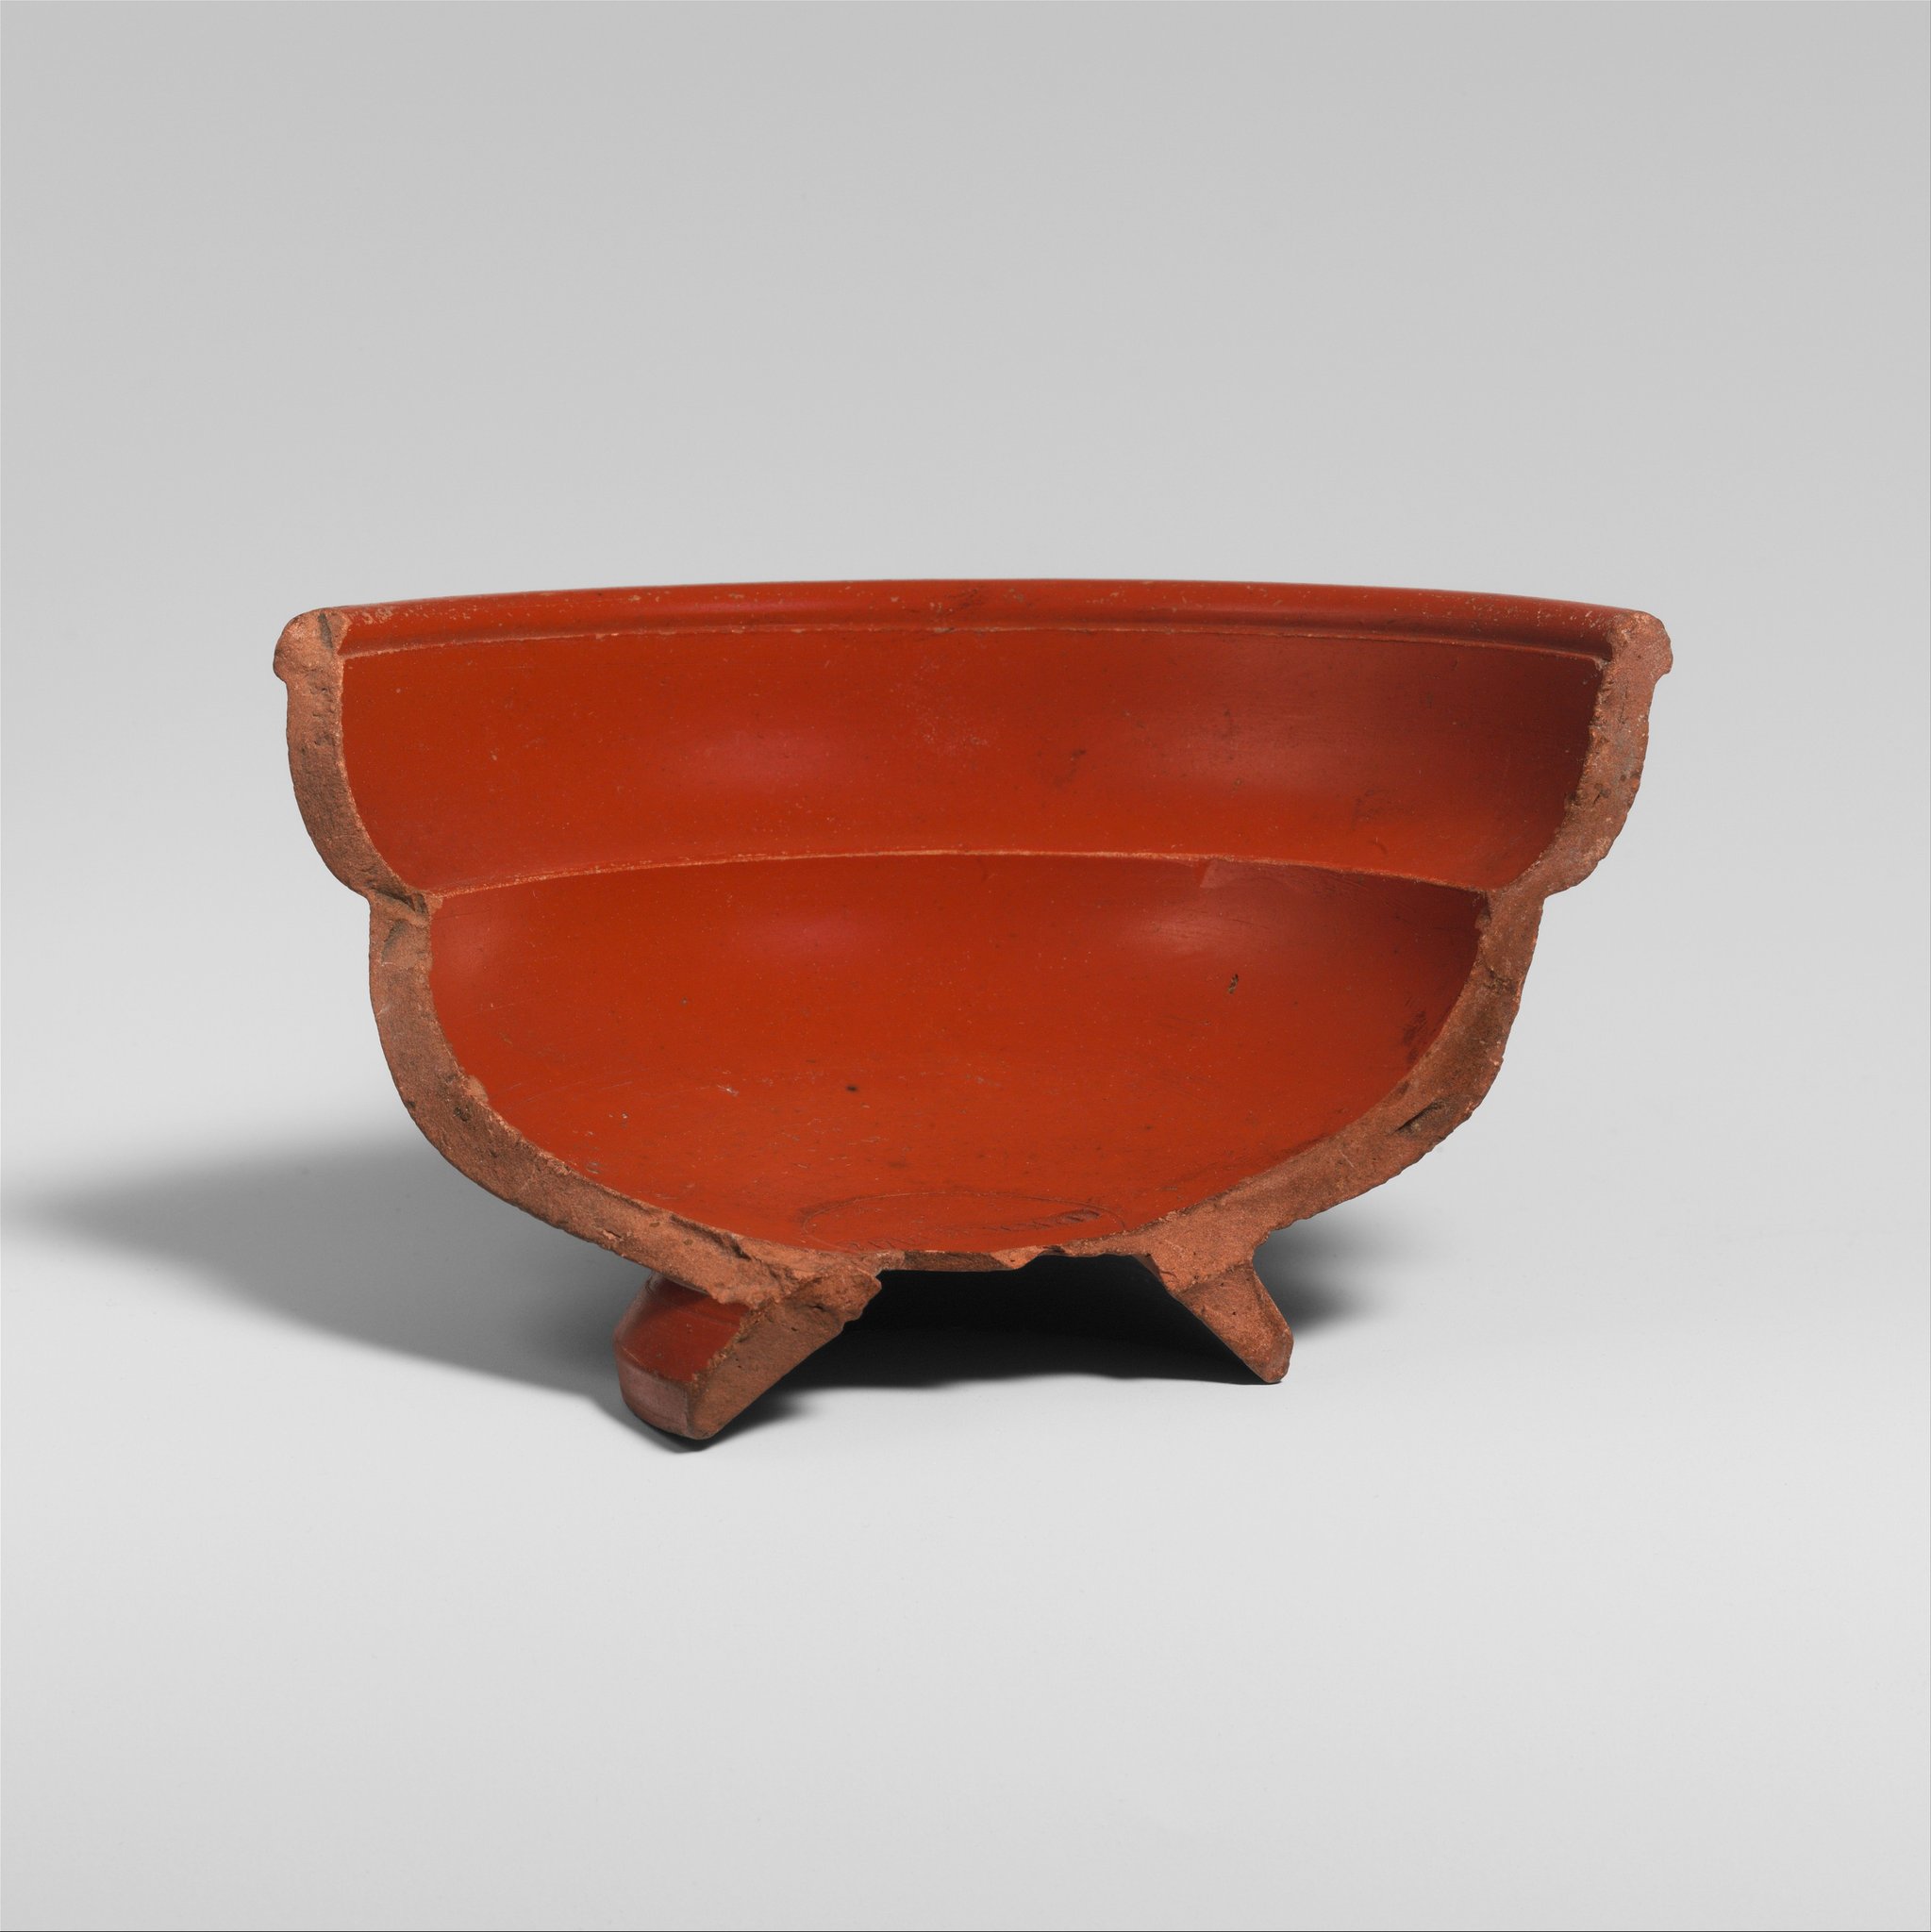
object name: cup, fragment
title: Fragmentary terracotta bowl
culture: roman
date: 1-100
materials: terracotta